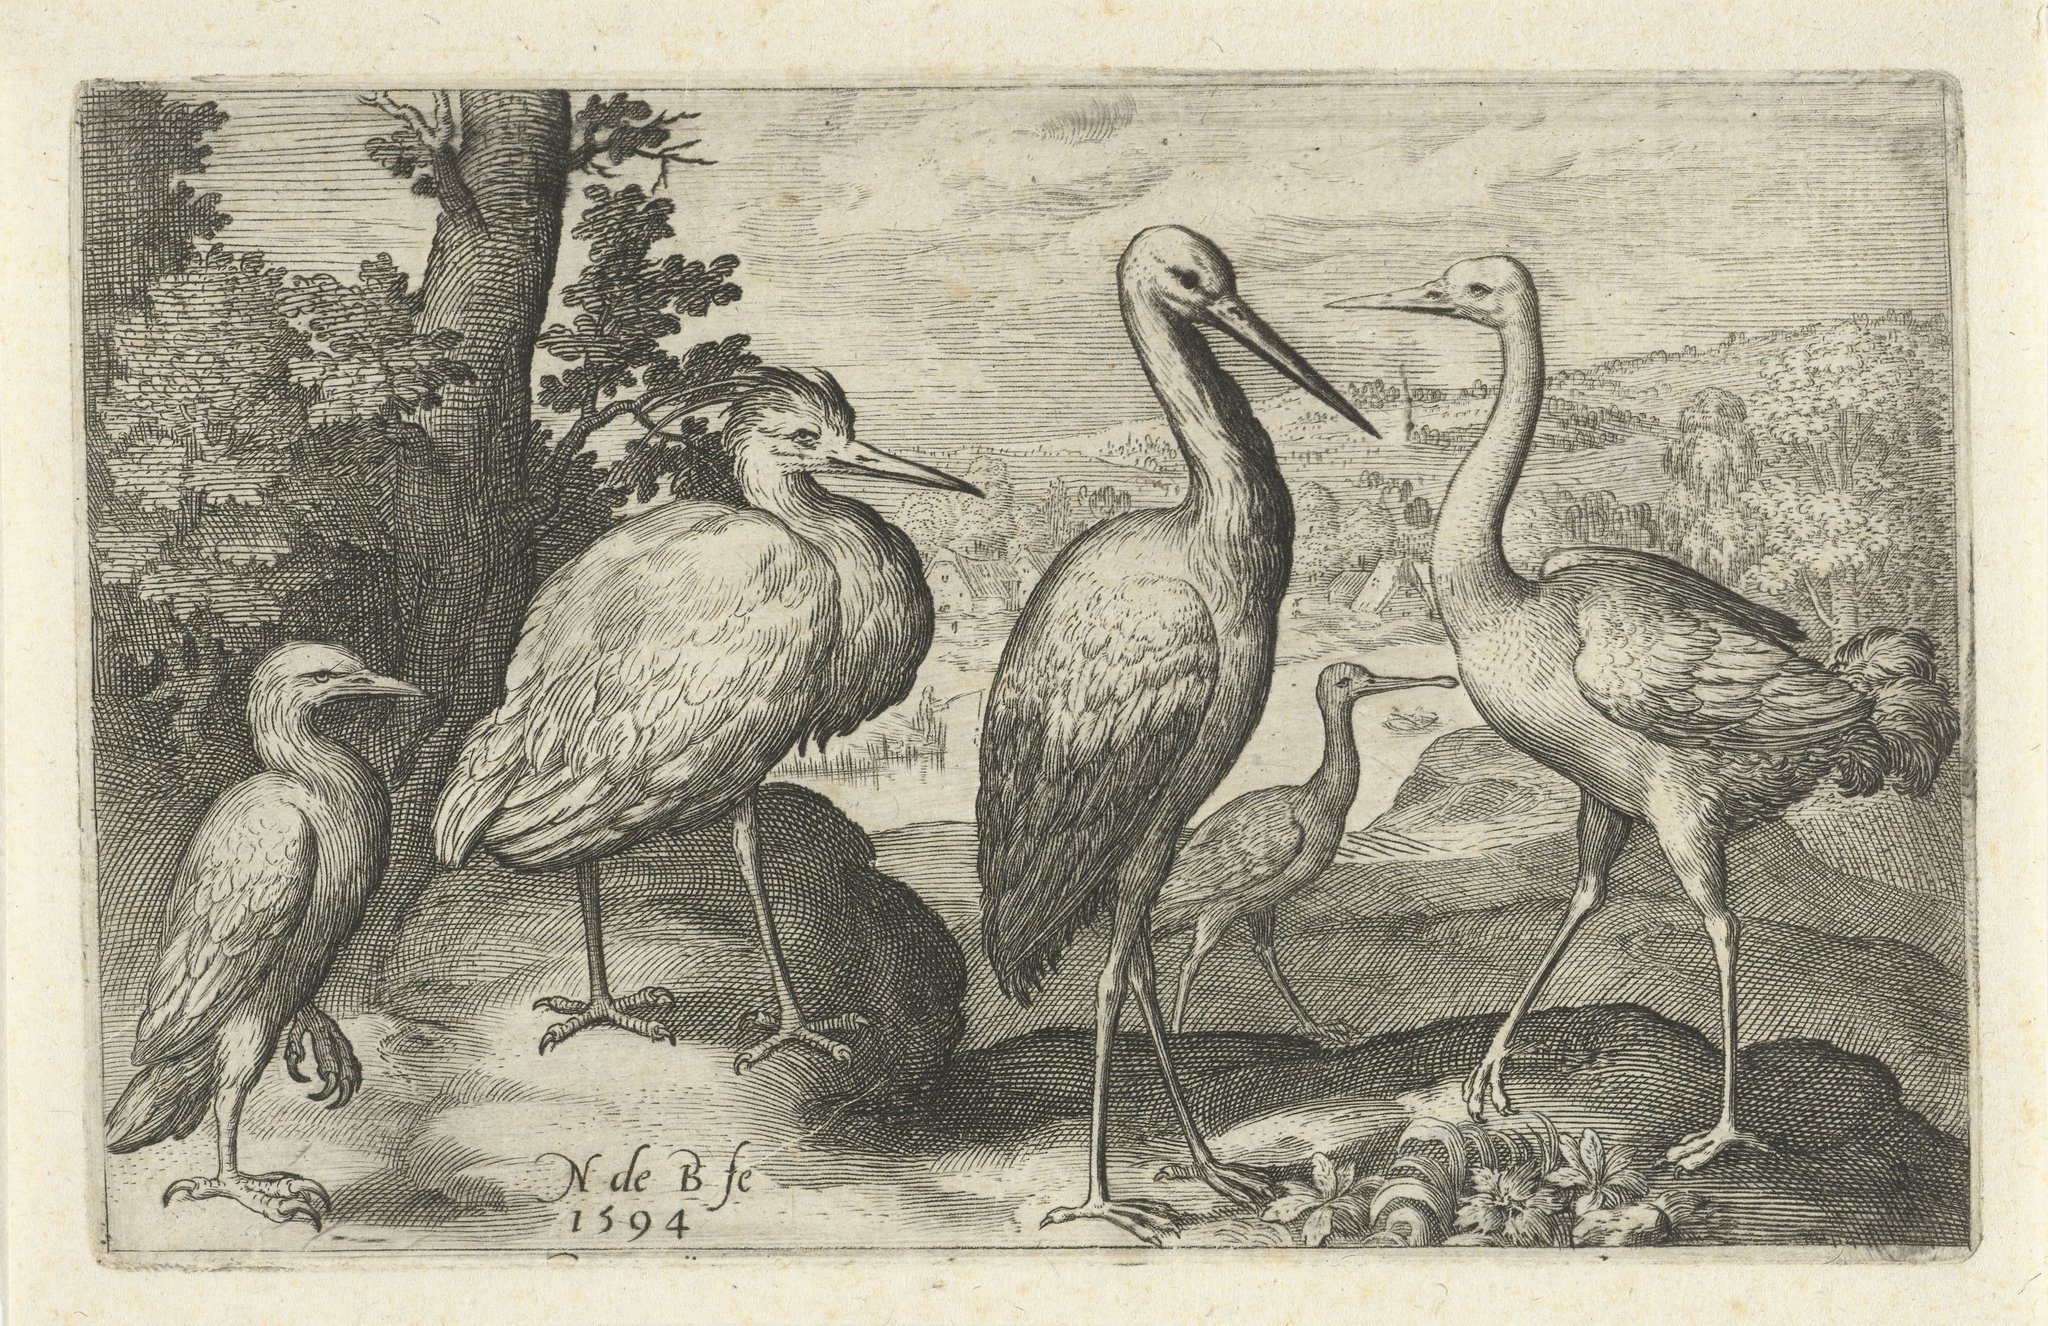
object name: print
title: Ooievaar, kraanvogel, reiger en lepelaar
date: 1594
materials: paper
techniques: engraving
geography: antwerp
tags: shore-birds and wading-birds: crane, shore-birds and wading-birds: stork, shore-birds and wading-birds: heron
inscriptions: collector's mark: Lugt 2228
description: Prent uit serie van twaalf prenten met vogels en insecten. Bij Hollstein zijn bladen van een andere serie prenten afgebeeld, zie De Groot 1988, p. 37.